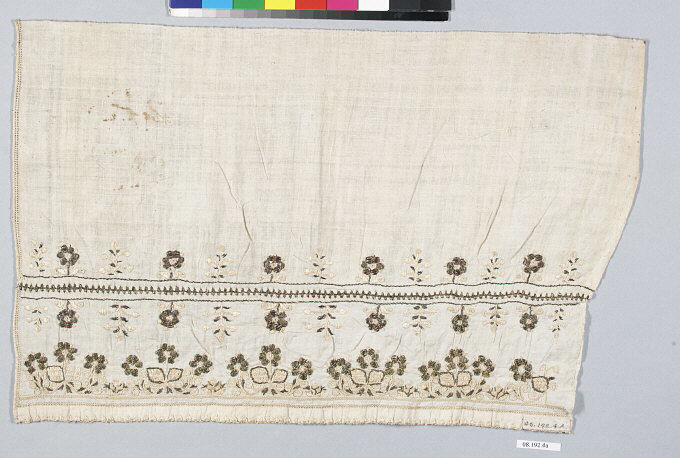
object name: cover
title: End of a cover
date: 1767-1833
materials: linen, silk